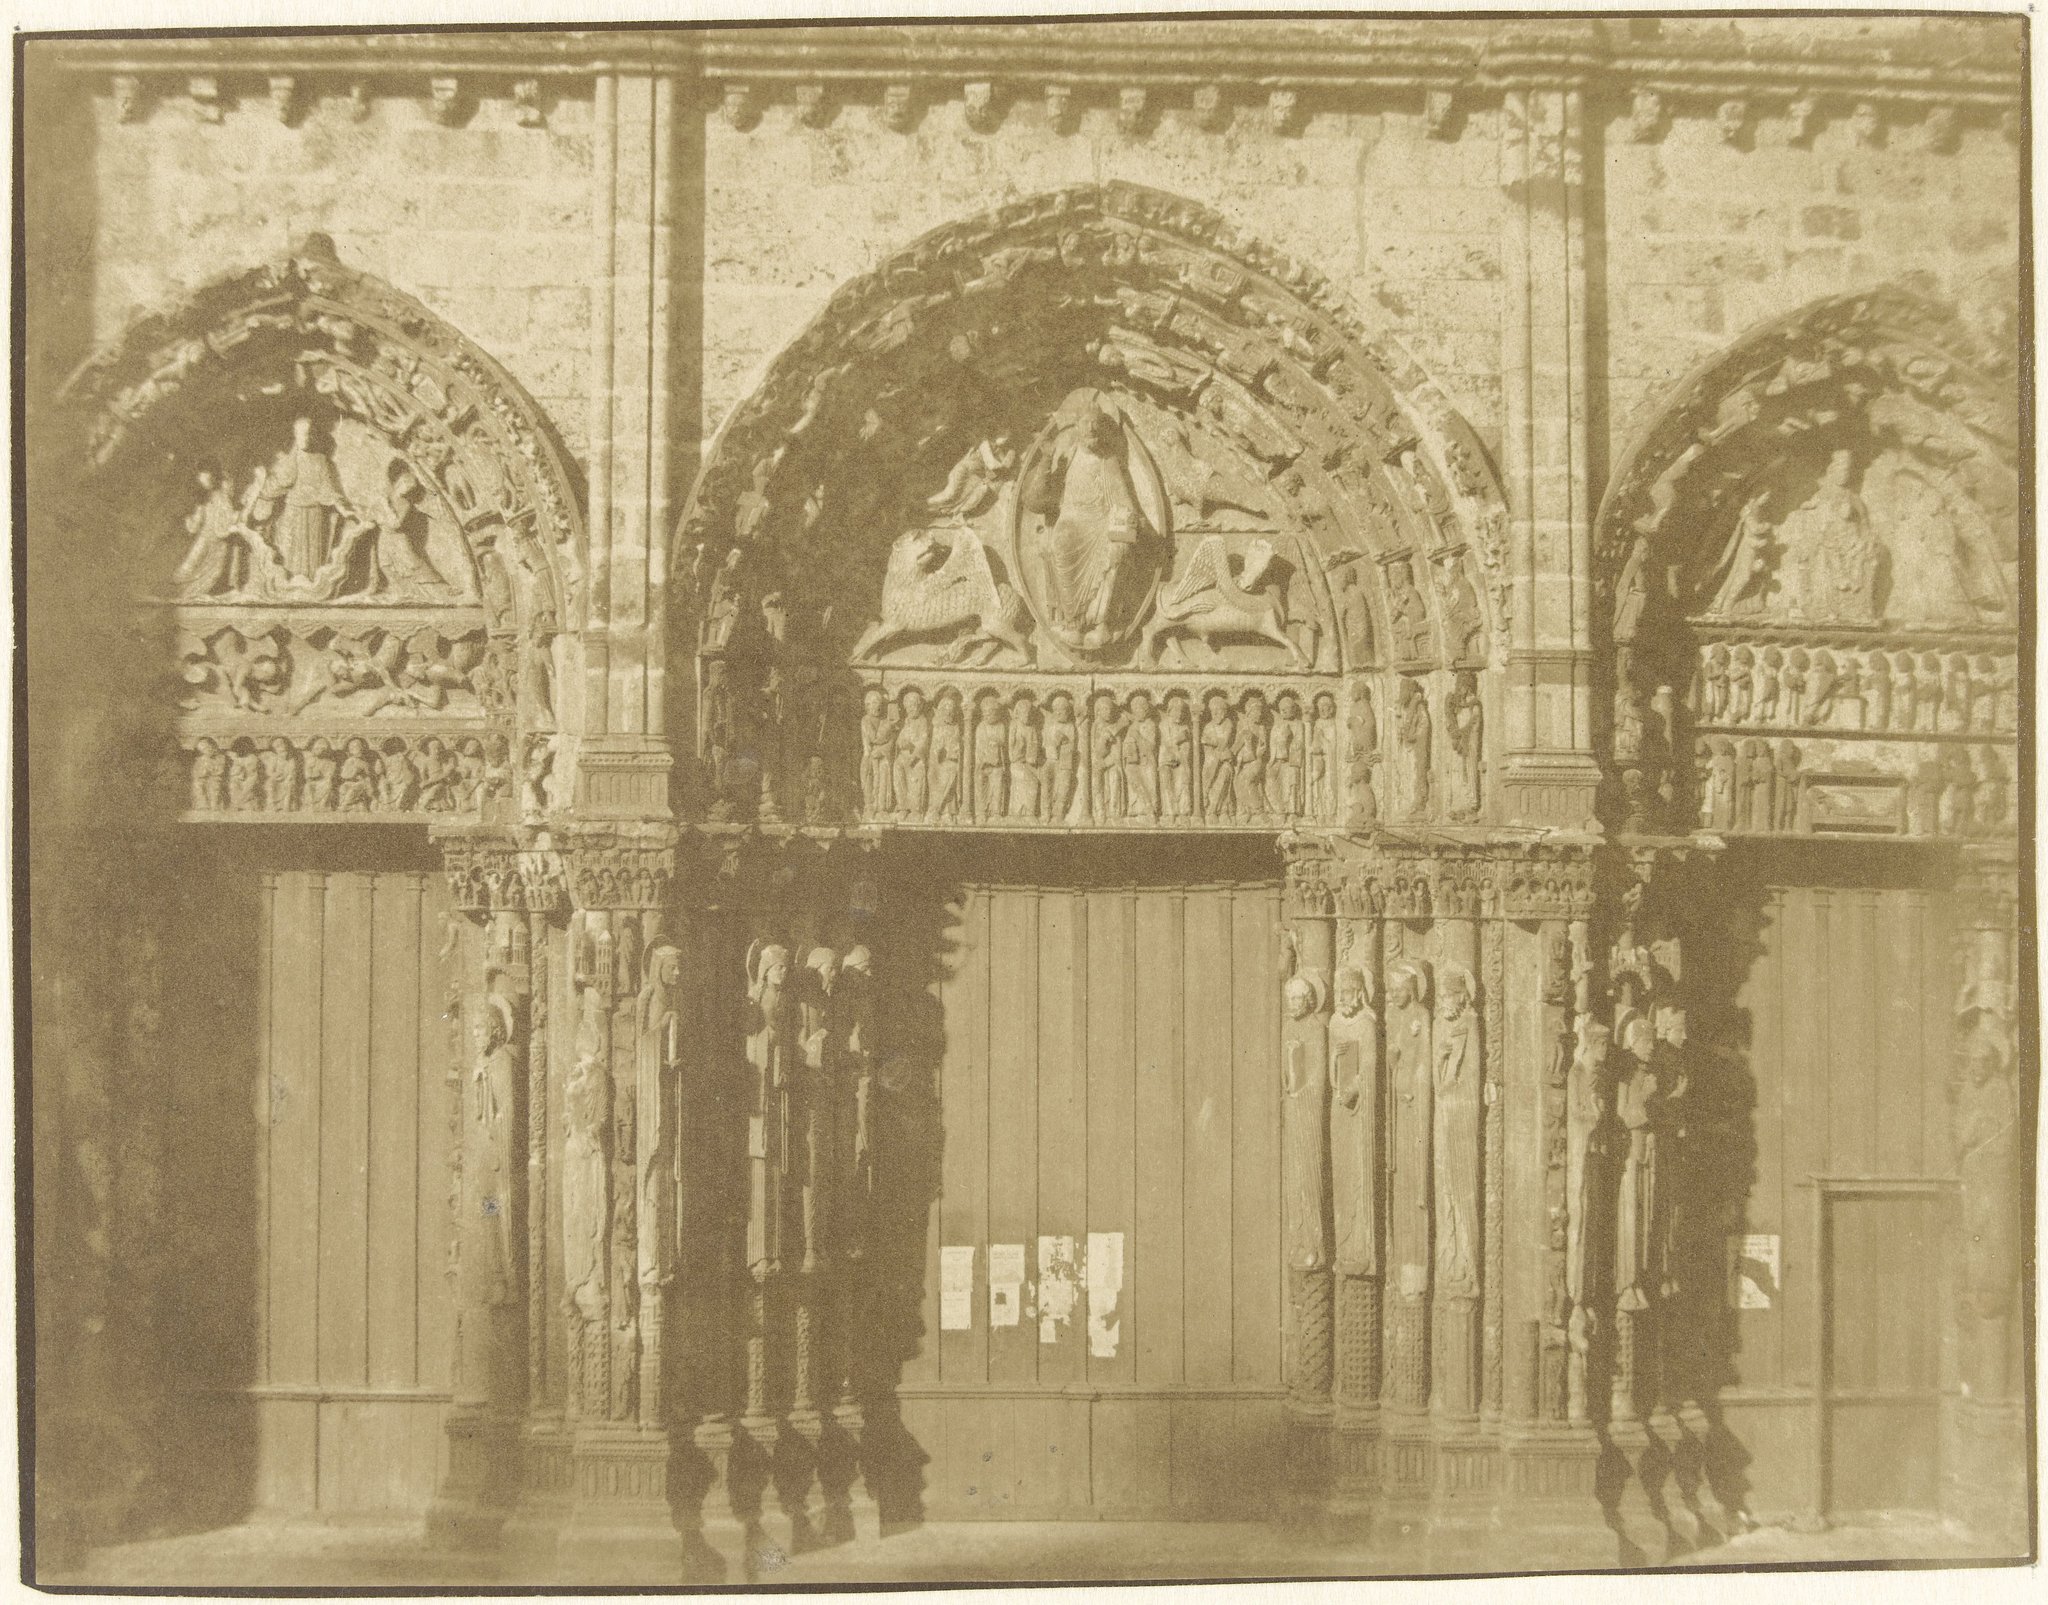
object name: photograph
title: Portaal van de kathedraal van Chartres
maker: charles nègre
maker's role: fotograaf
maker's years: 1820-1880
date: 1854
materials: paper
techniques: albumen print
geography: chartres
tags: parts of church exterior and annexes: portal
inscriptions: number: ‘624’